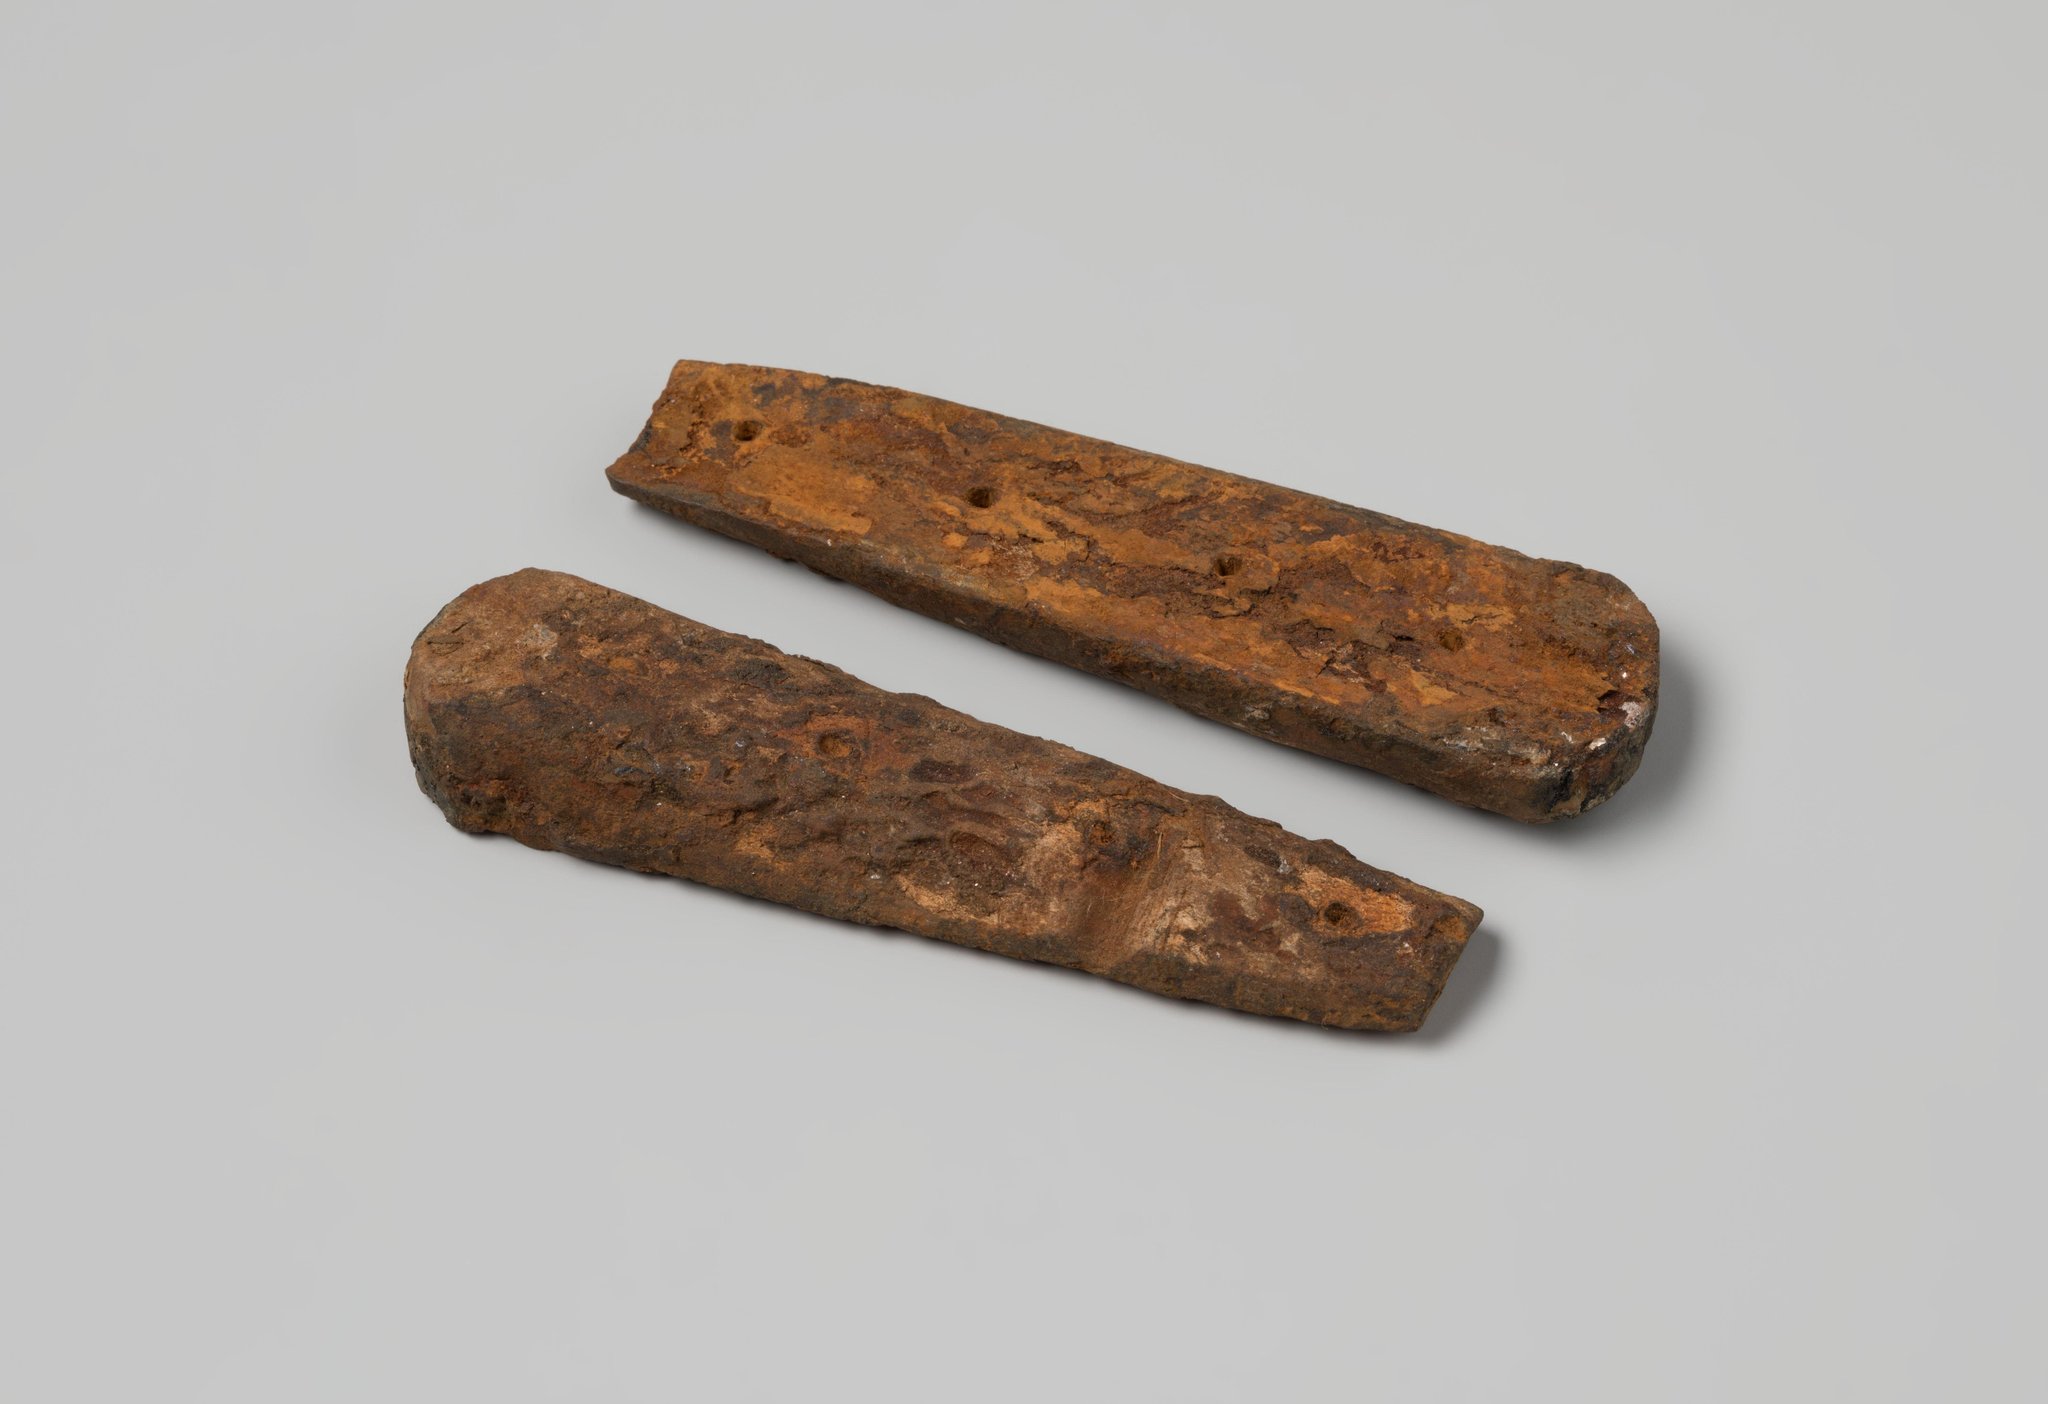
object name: knife handle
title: Messenheft uit het wrak van de Oost-Indiëvaarder Hollandia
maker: Anonymous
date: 1700-1743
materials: bone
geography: netherlands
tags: verenigde oostindische compagnie, hollandia (schip), annet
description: Knife-handle, tangplate; flat, tapering strips, semicircular upper end, 4 rivet-holes.